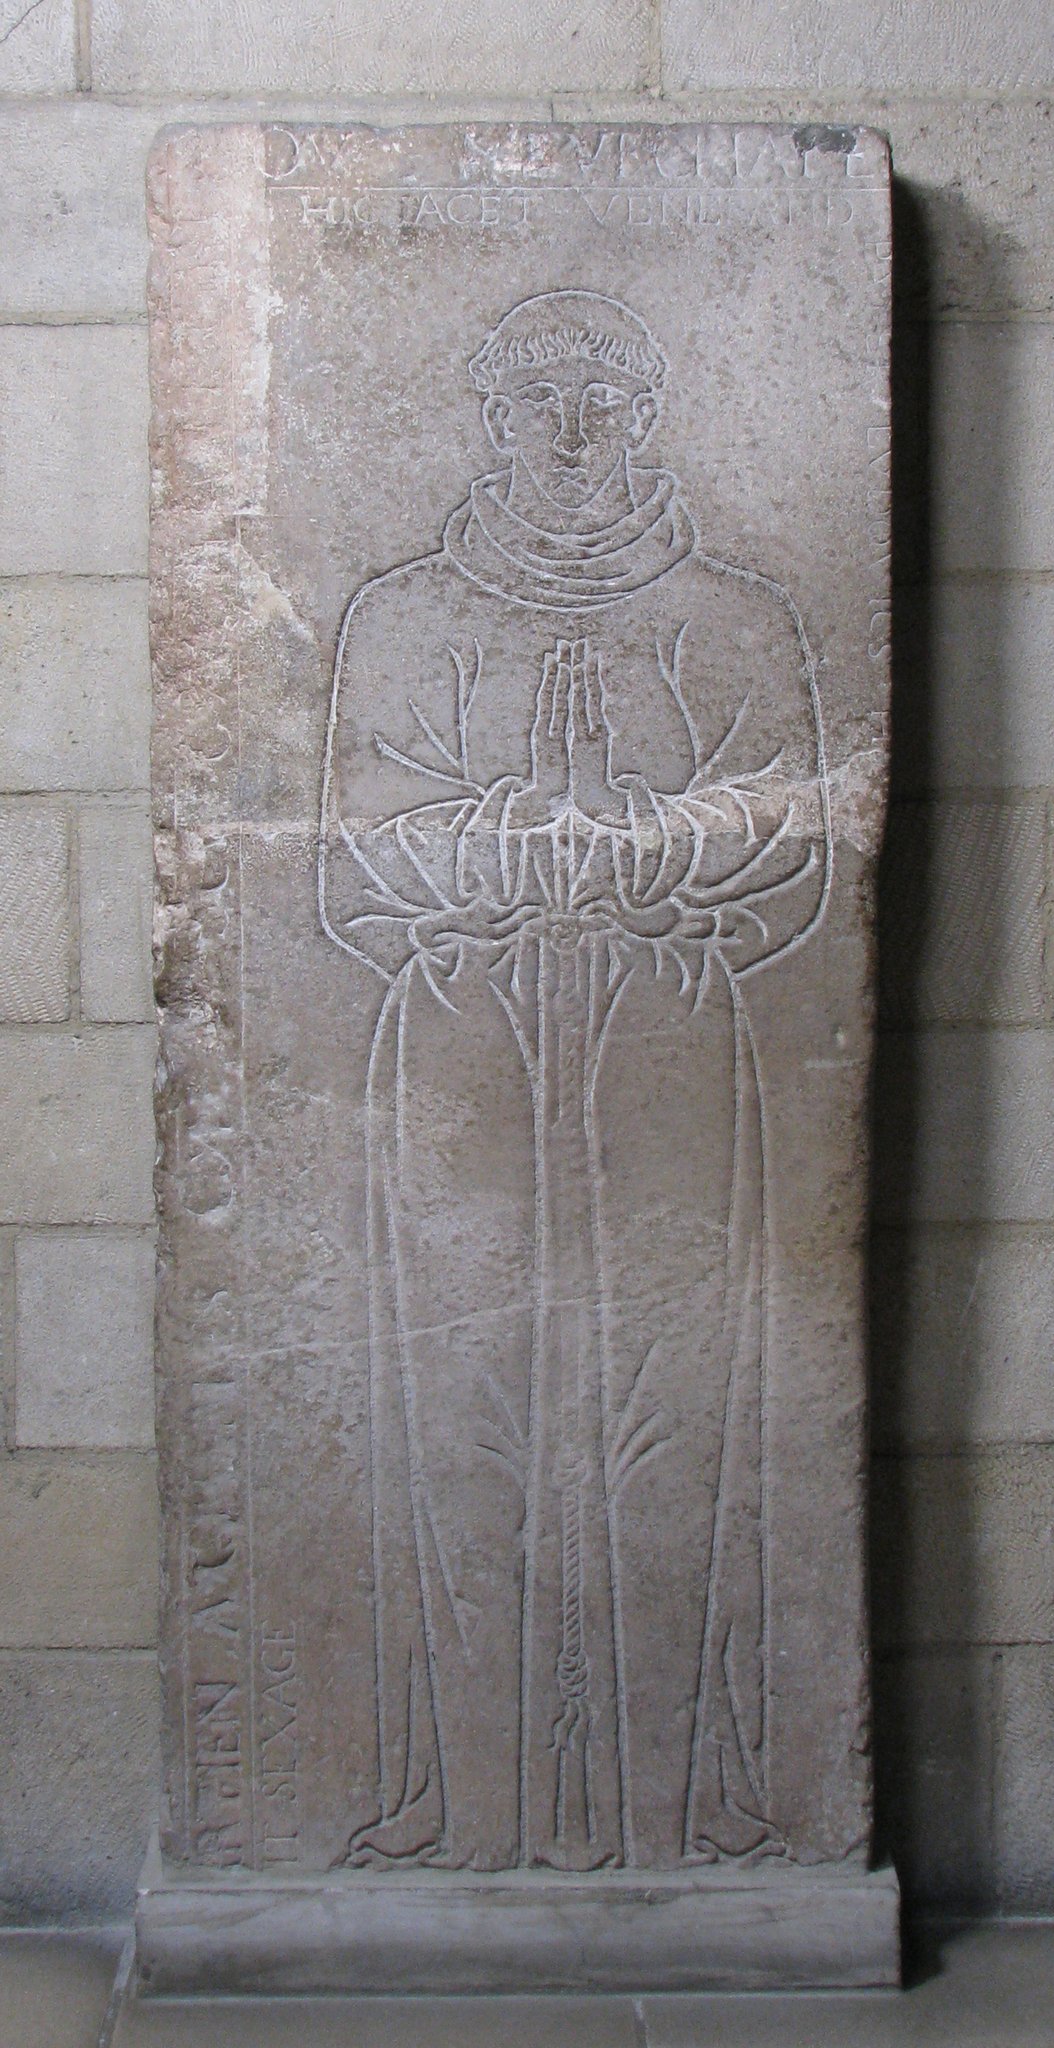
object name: tomb slab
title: Tomb Slab of a Monk (Father Louis)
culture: french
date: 1301-1400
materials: stone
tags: men,monks